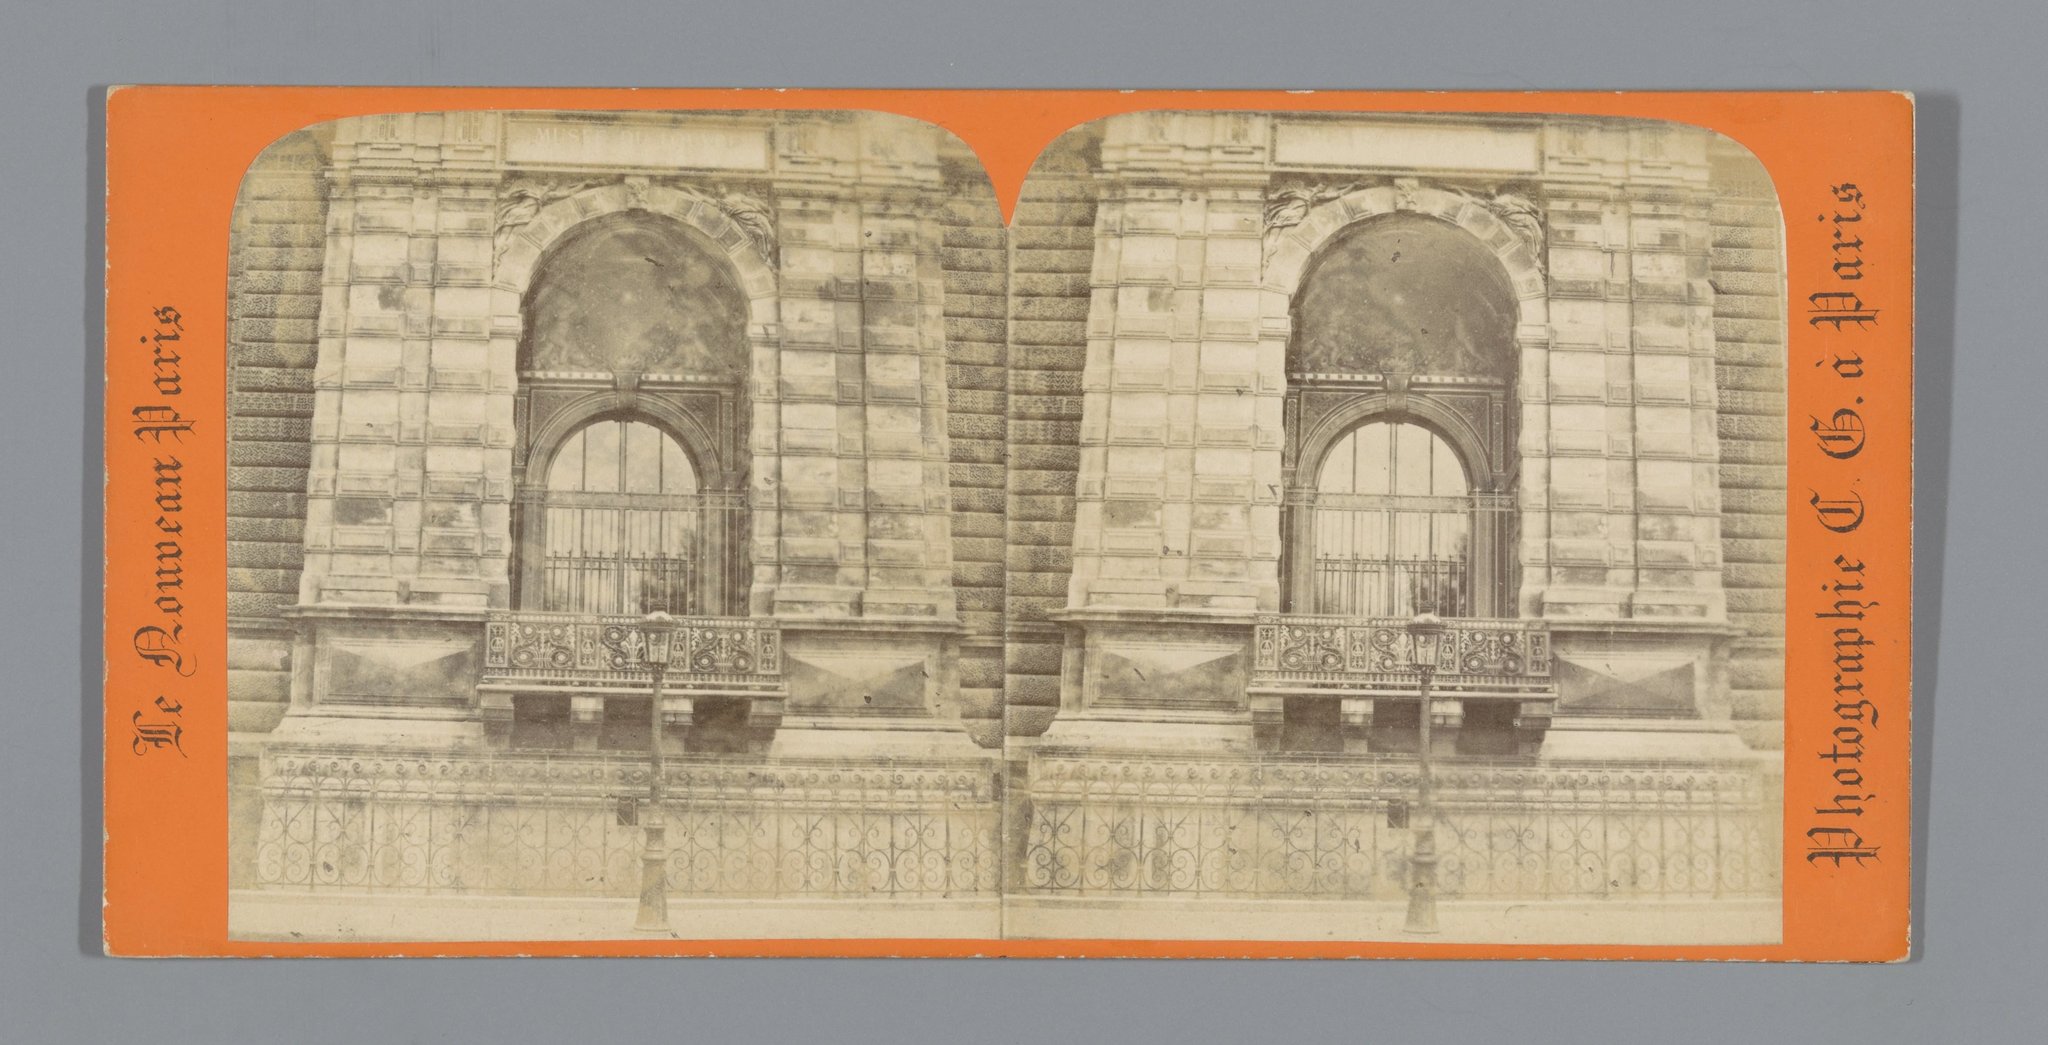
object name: stereograph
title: Le nouveau Paris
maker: charles gérard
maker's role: fotograaf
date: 1866-1870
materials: cardboard, paper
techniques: albumen print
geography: paris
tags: balcony